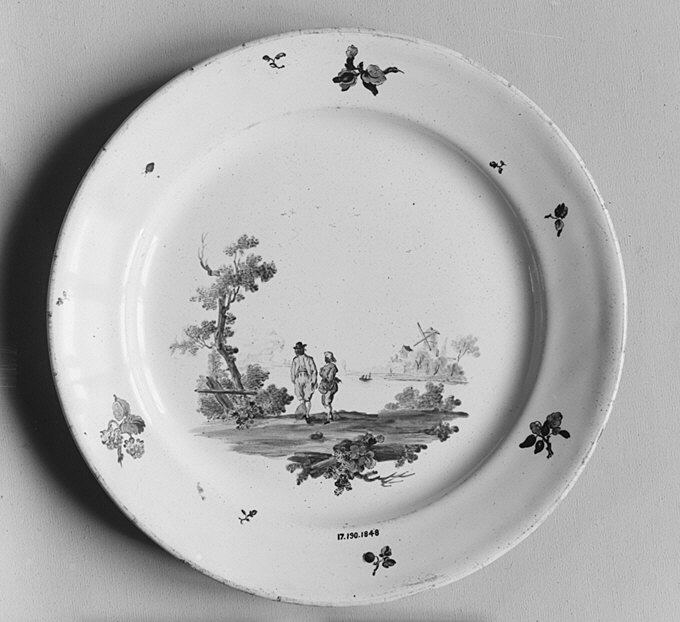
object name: plate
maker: fidelle duvivier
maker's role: decorator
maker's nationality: french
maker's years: 1740-1796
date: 1753-1795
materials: faience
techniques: glazing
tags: windmills,men,women,trees